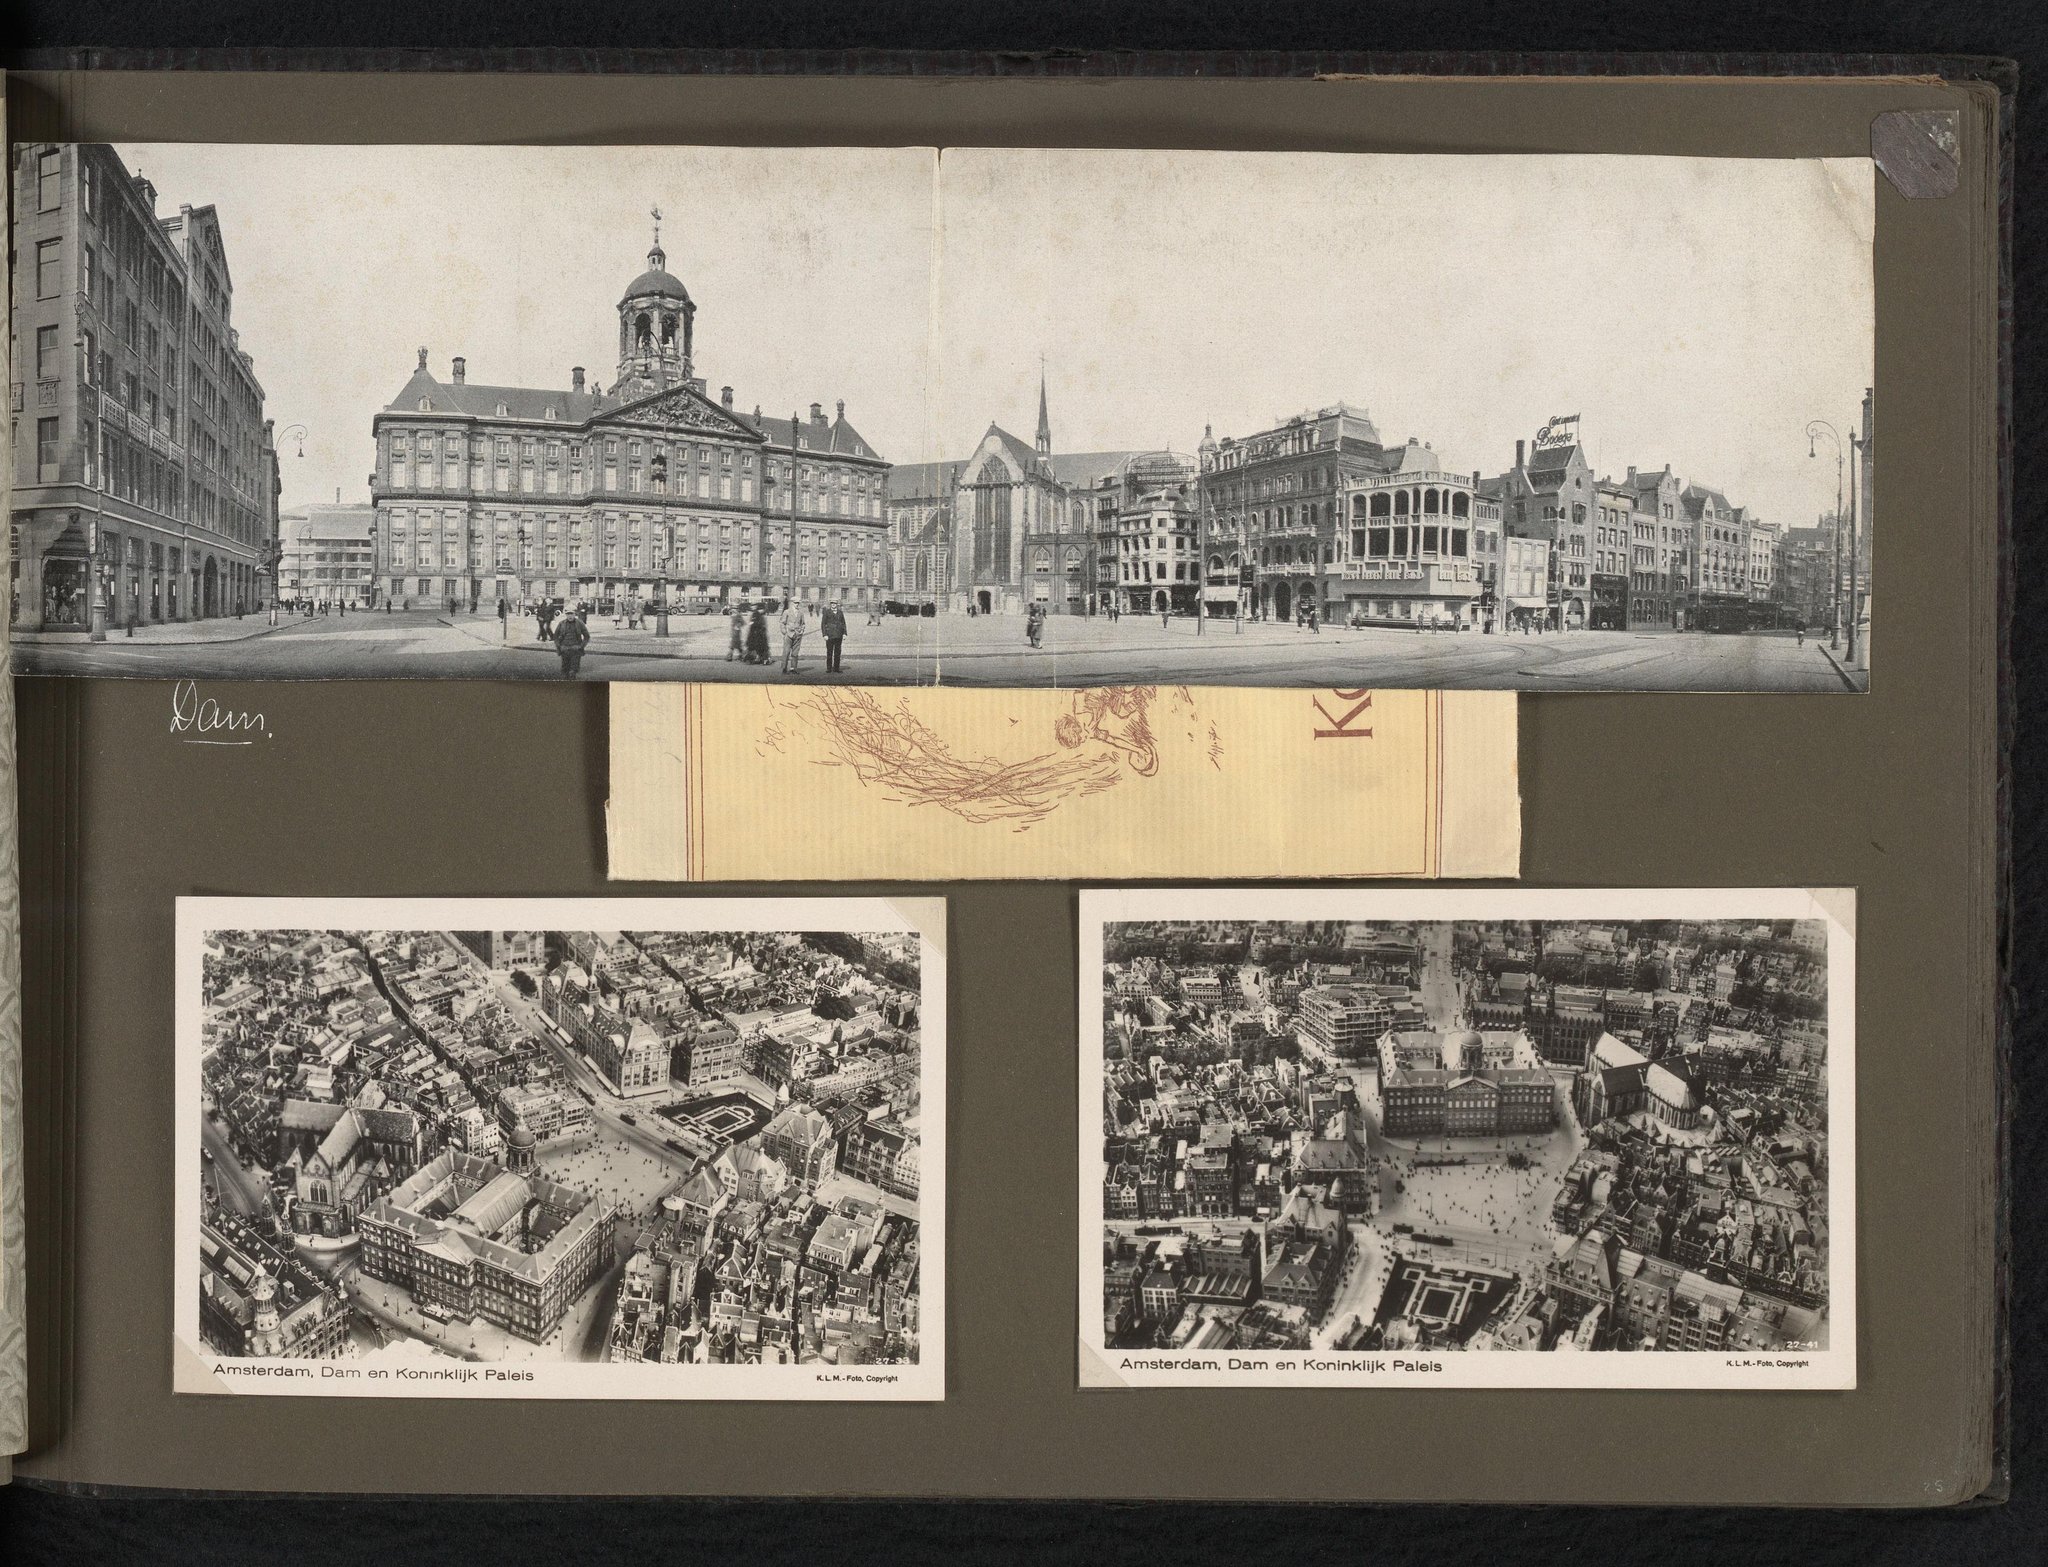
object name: ansichtkaart, prentbriefkaart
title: Dam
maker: Anonymous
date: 1910-1931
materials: paper, cardboard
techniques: gelatin silver print, letterpress printing, photolithography, printing block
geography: amsterdam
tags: palace - aa - civic architecture: inside, square, place, circus, etc., palace, royal palace of amsterdam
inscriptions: inscription: ‘Amsterdam, Dam en Koninklijk Paleis’, inscription: ‘Amsterdam, Dam en Koninklijk Paleis’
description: Deze foto's en prenten maken deel uit van een album.